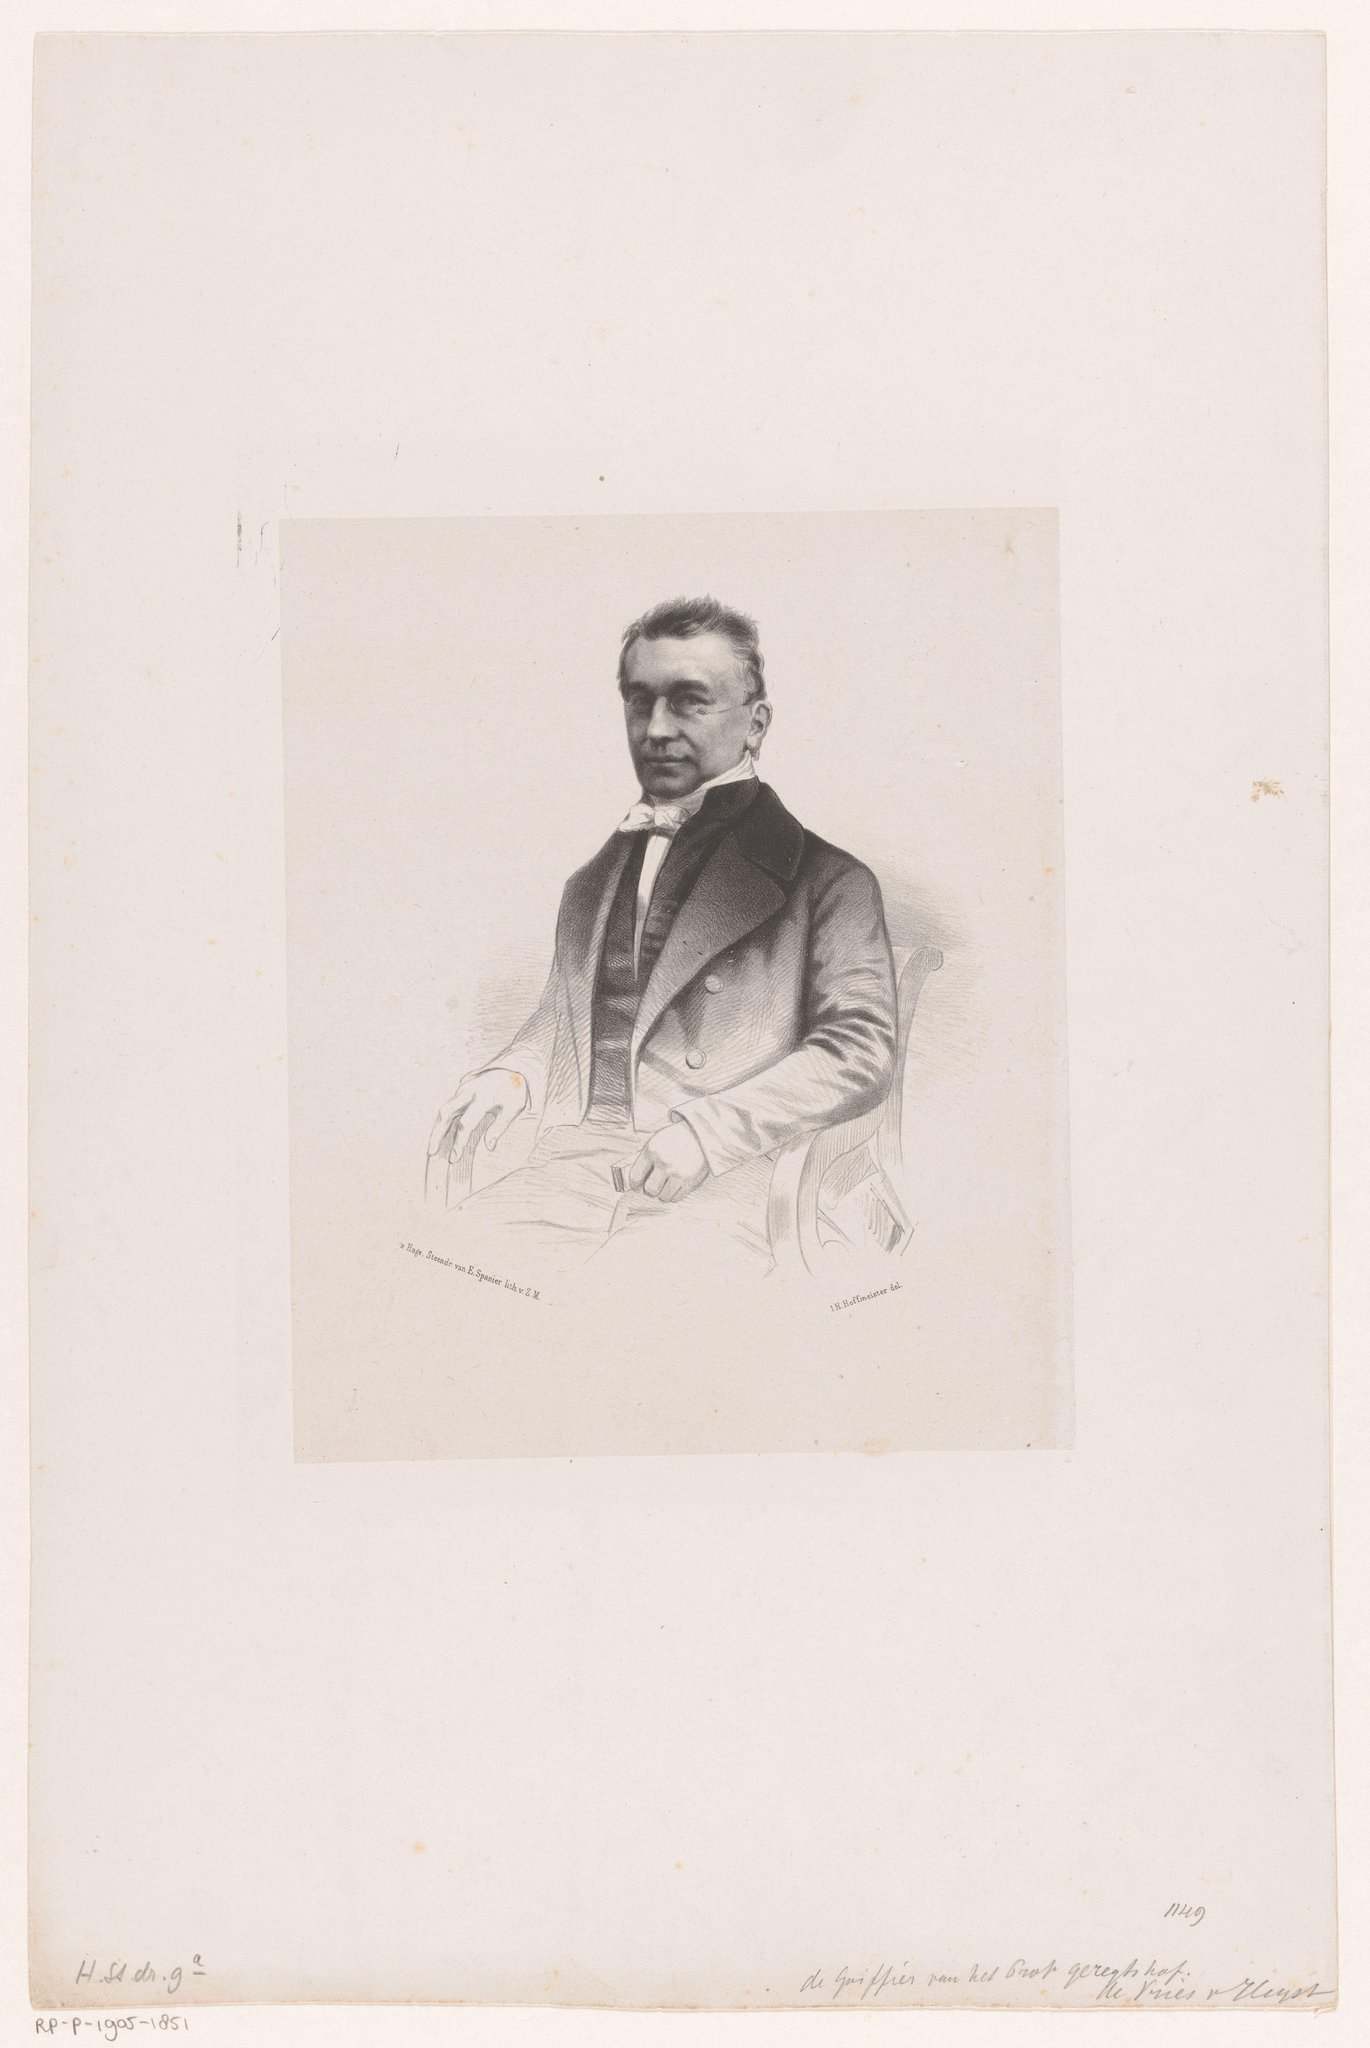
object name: print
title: Portret van Fr. Mar. de Vries van Heyst.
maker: johan hendrik hoffmeister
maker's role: print maker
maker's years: 1823-1904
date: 1851-1883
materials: paper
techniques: lithograph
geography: netherlands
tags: the hague, eyeglasses, spectacles, historical persons (+ (full) bust portrait)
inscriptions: collector's mark: Lugt 2228